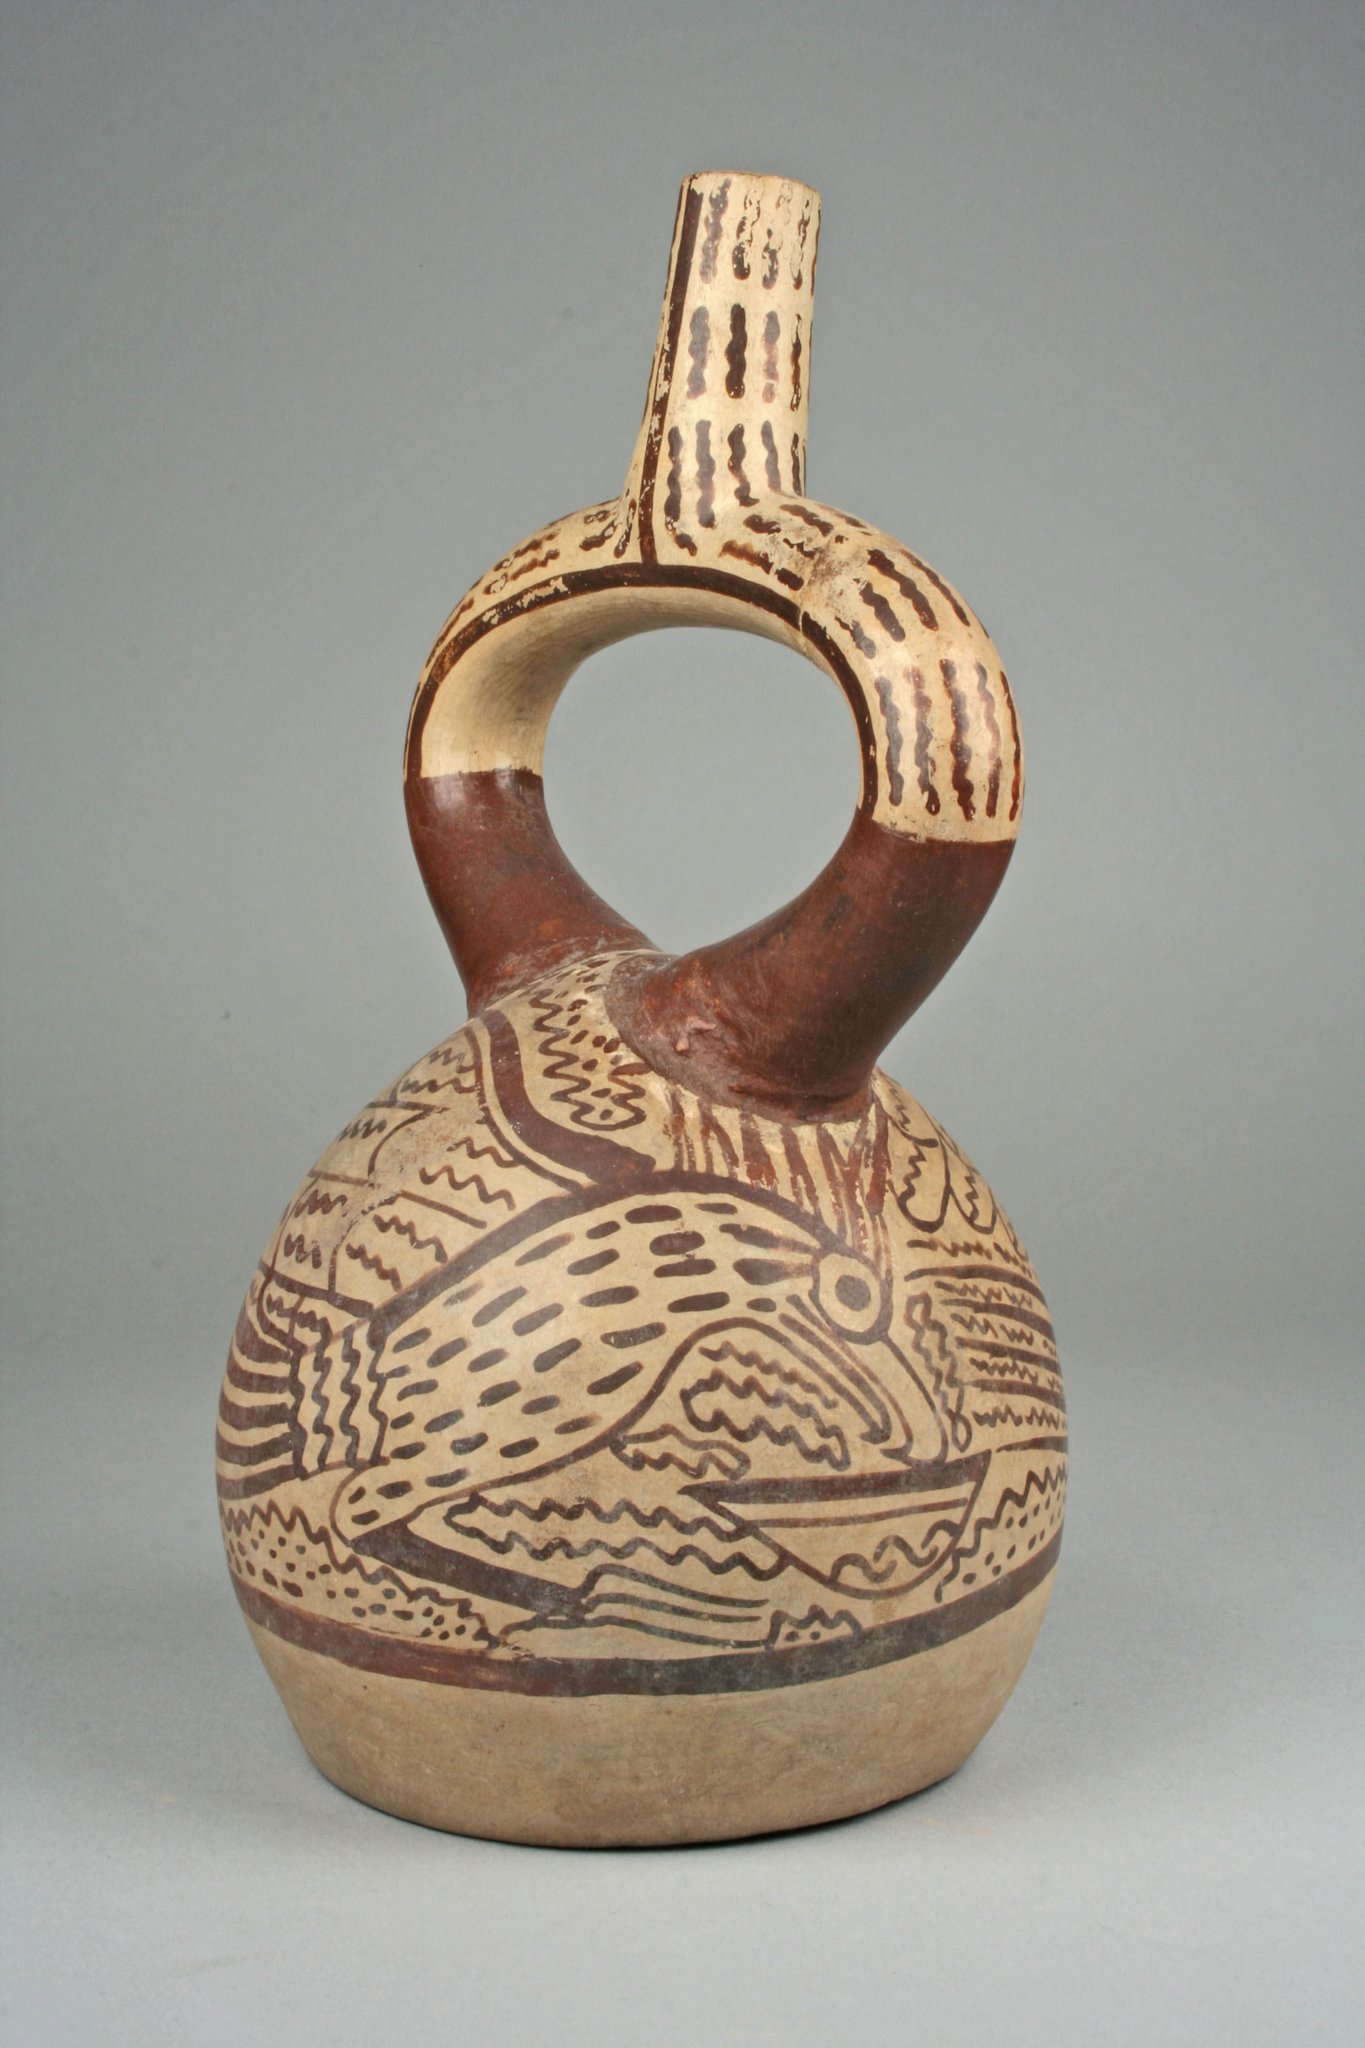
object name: bottle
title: Stirrup spout bottle with hawk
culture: moche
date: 501-700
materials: ceramic, pigment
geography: peru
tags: hawks